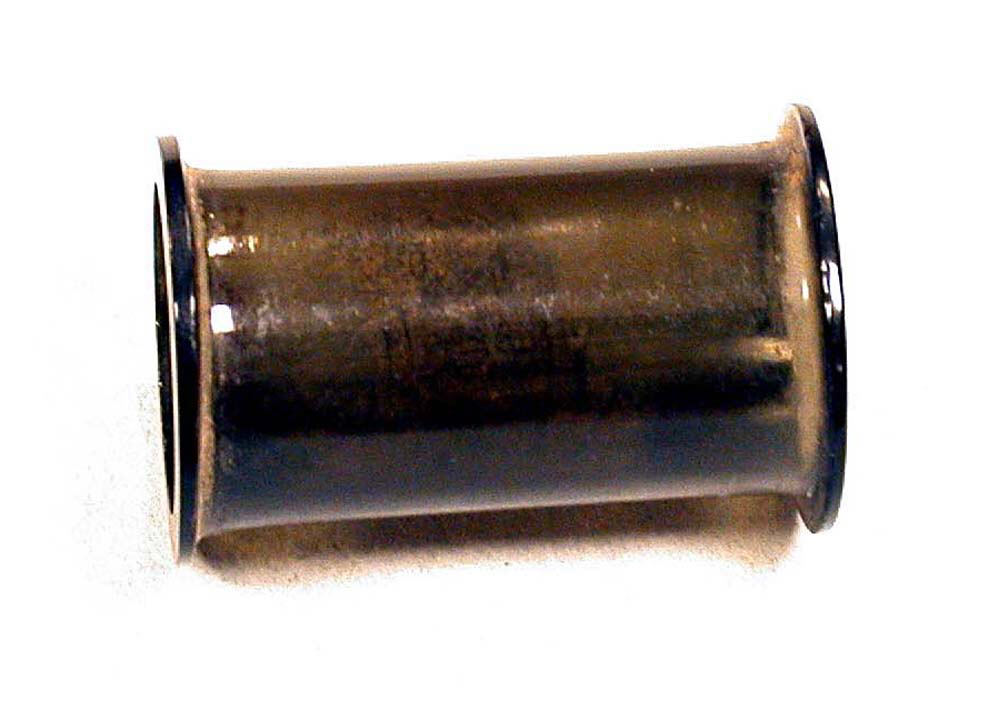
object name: ear spool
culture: mexican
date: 1501-1600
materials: obsidian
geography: mexico